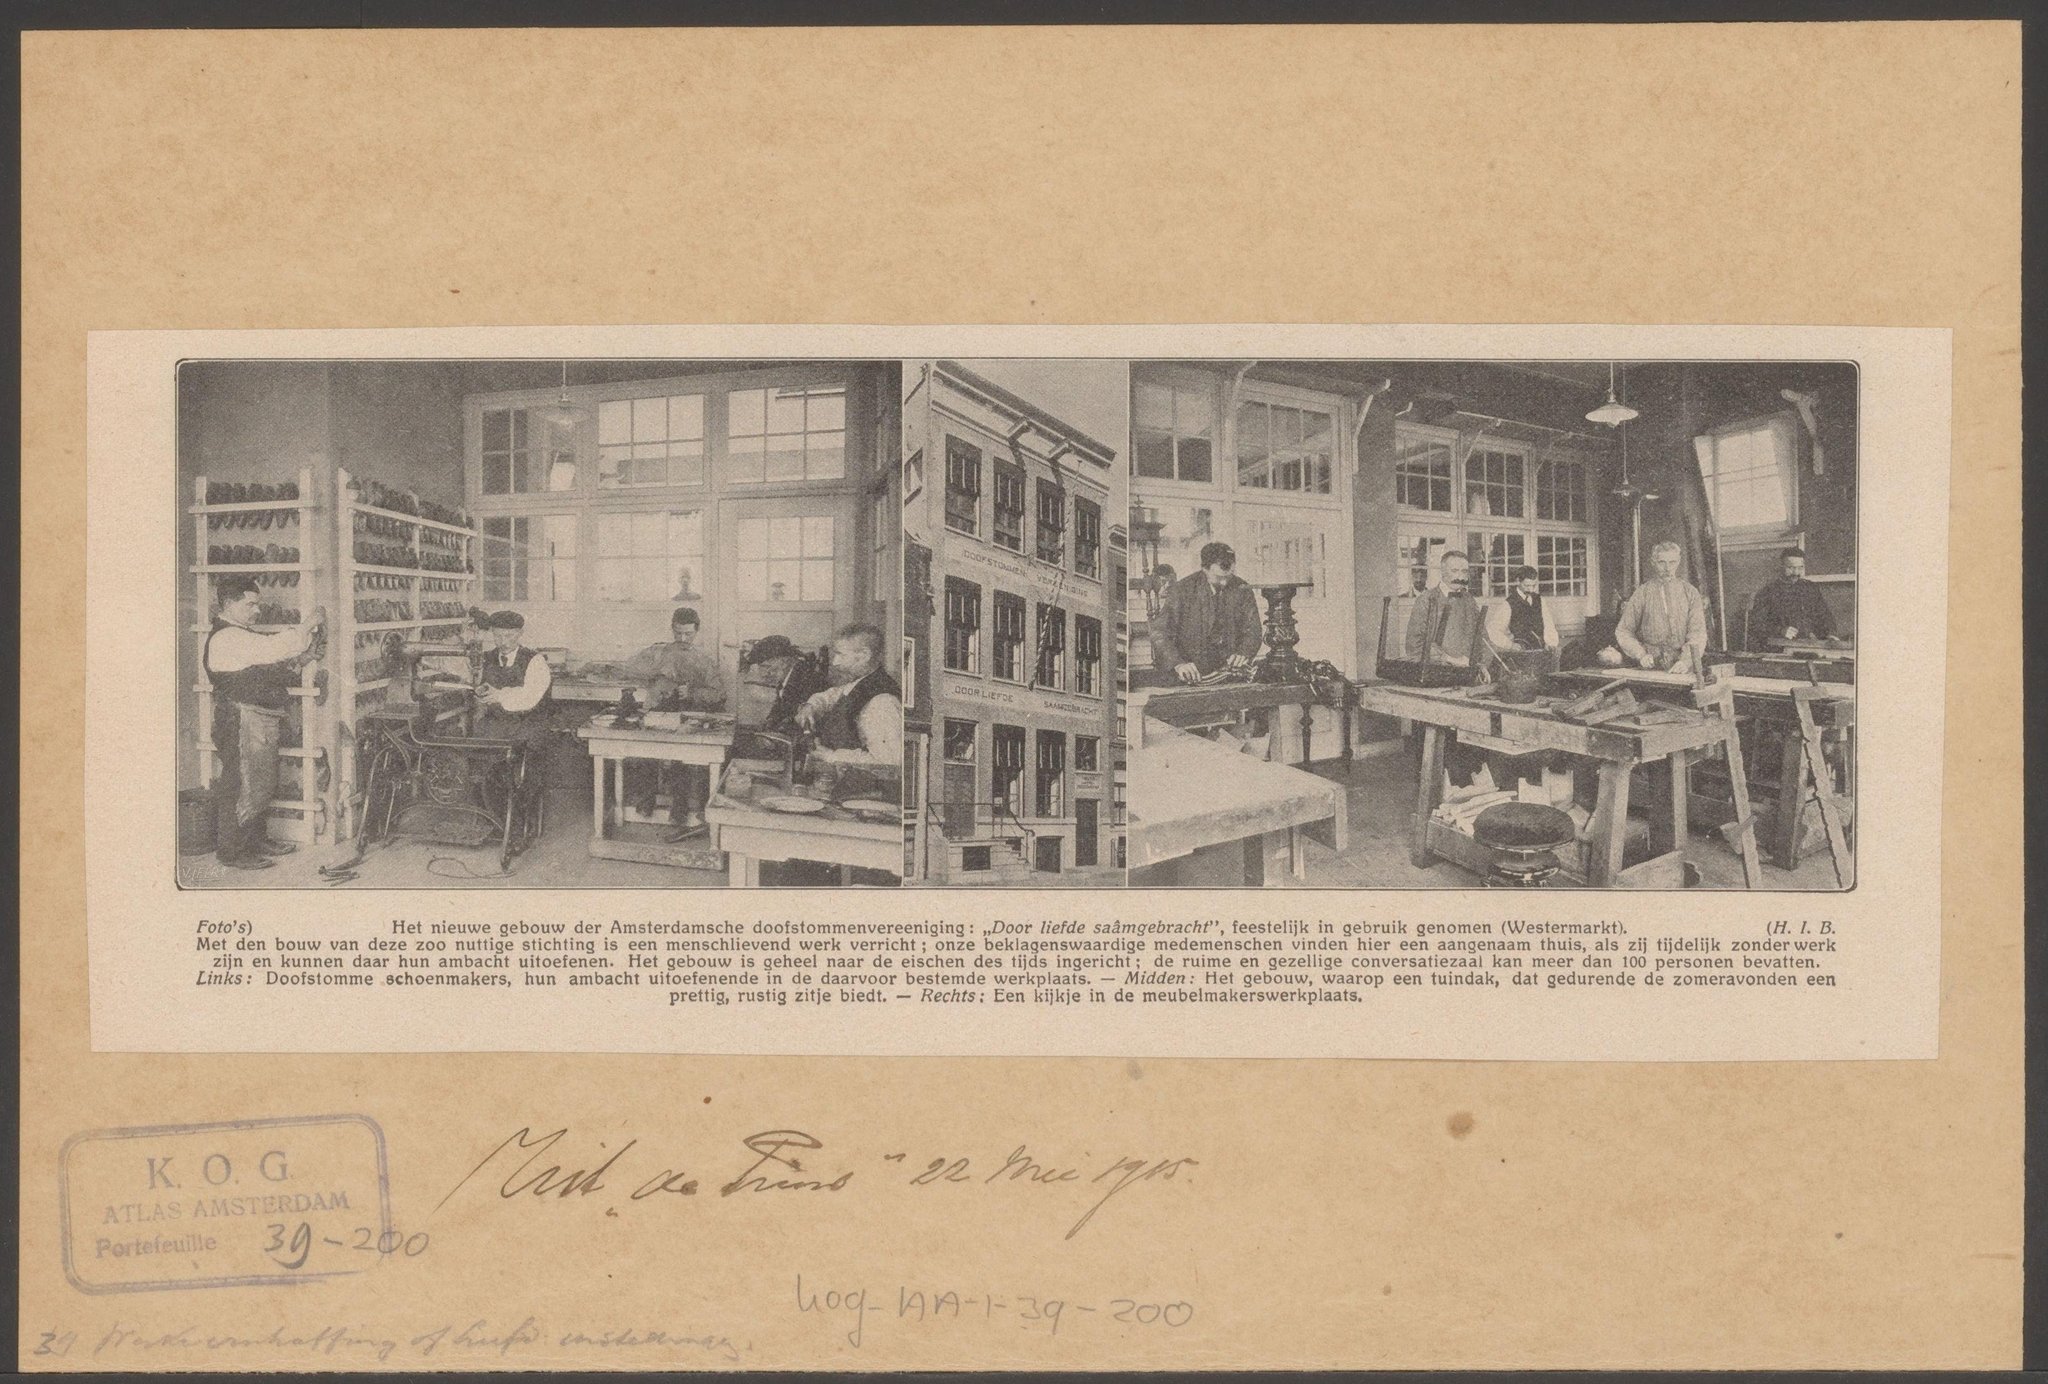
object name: photomechanical print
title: Doven aan het werk als schoen- en meubelmakers en gezicht op het gebouw van dovenvereniging Door Liefde Saâmgebracht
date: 1915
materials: paper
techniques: letterpress printing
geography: amsterdam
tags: carpenter, deaf, deafness, civic architecture; edifices; dwellings, shoe-maker, cobbler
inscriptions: collector's mark: Lugt 1641b, signature: ‘H.I.B.’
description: Onderwerpsrubriek binnen de Atlas Amsterdam: Armwezen en liefdadige instellingen: V. Ziekenhuizen: Ver. voor Ziekenverpleging aan de Prinsengracht.